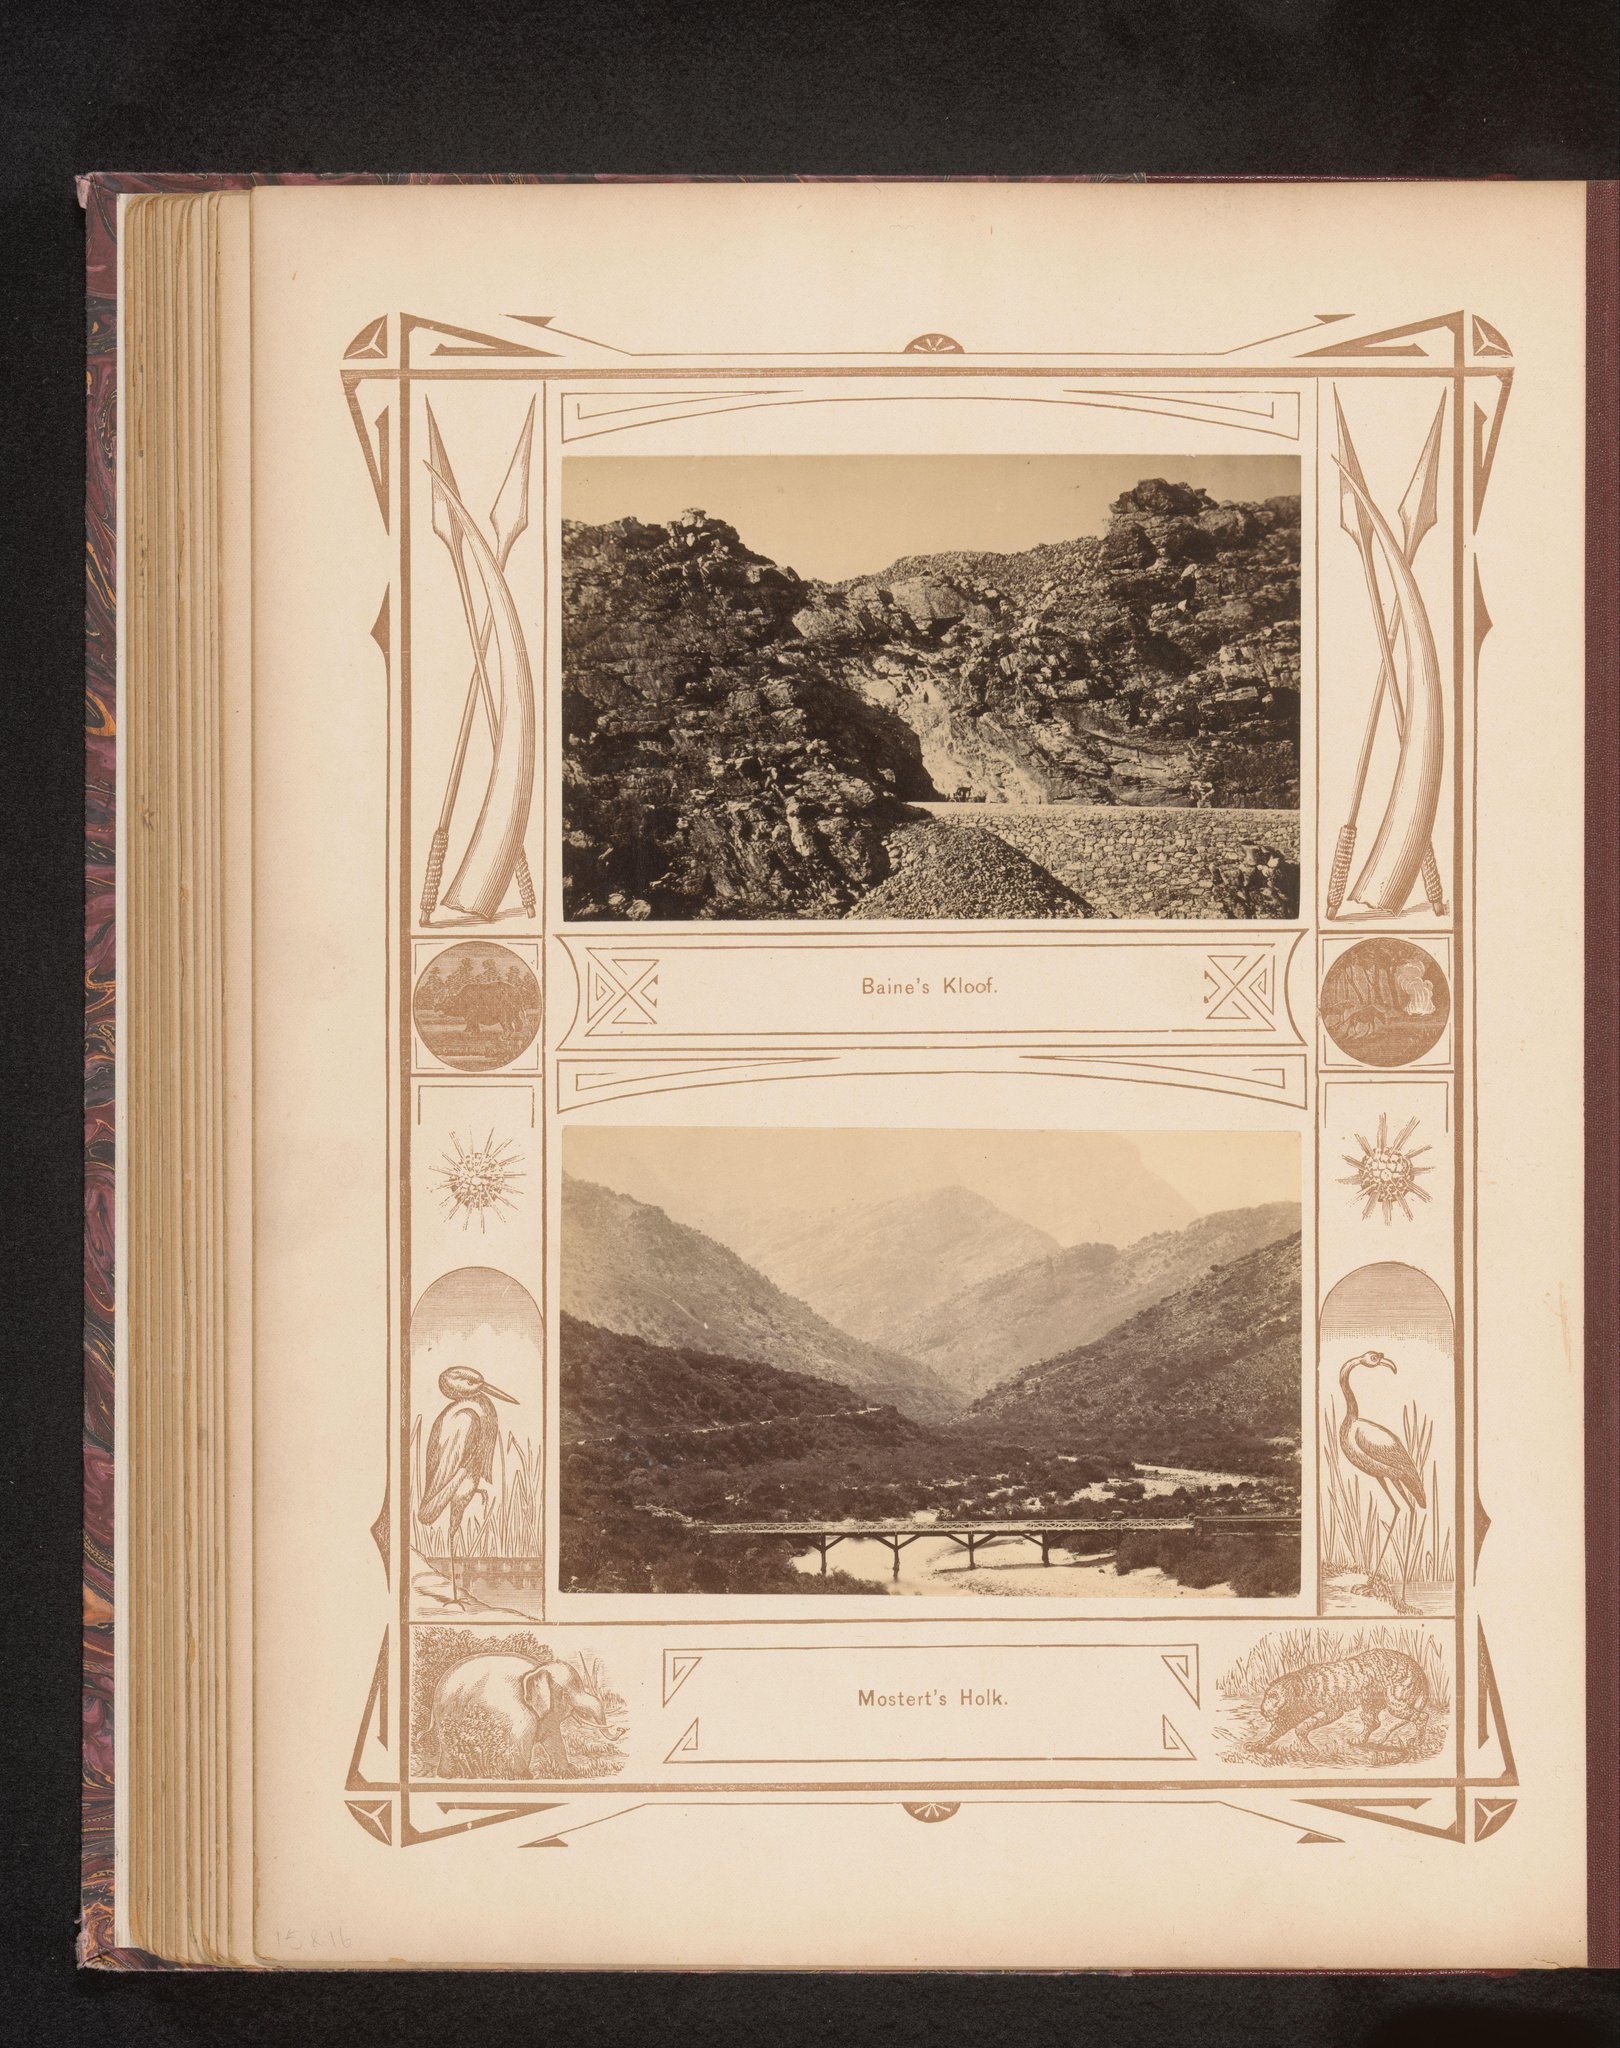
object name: page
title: Baine's Kloof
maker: Anonymous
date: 1877-1882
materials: photographic support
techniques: albumen print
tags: mountains